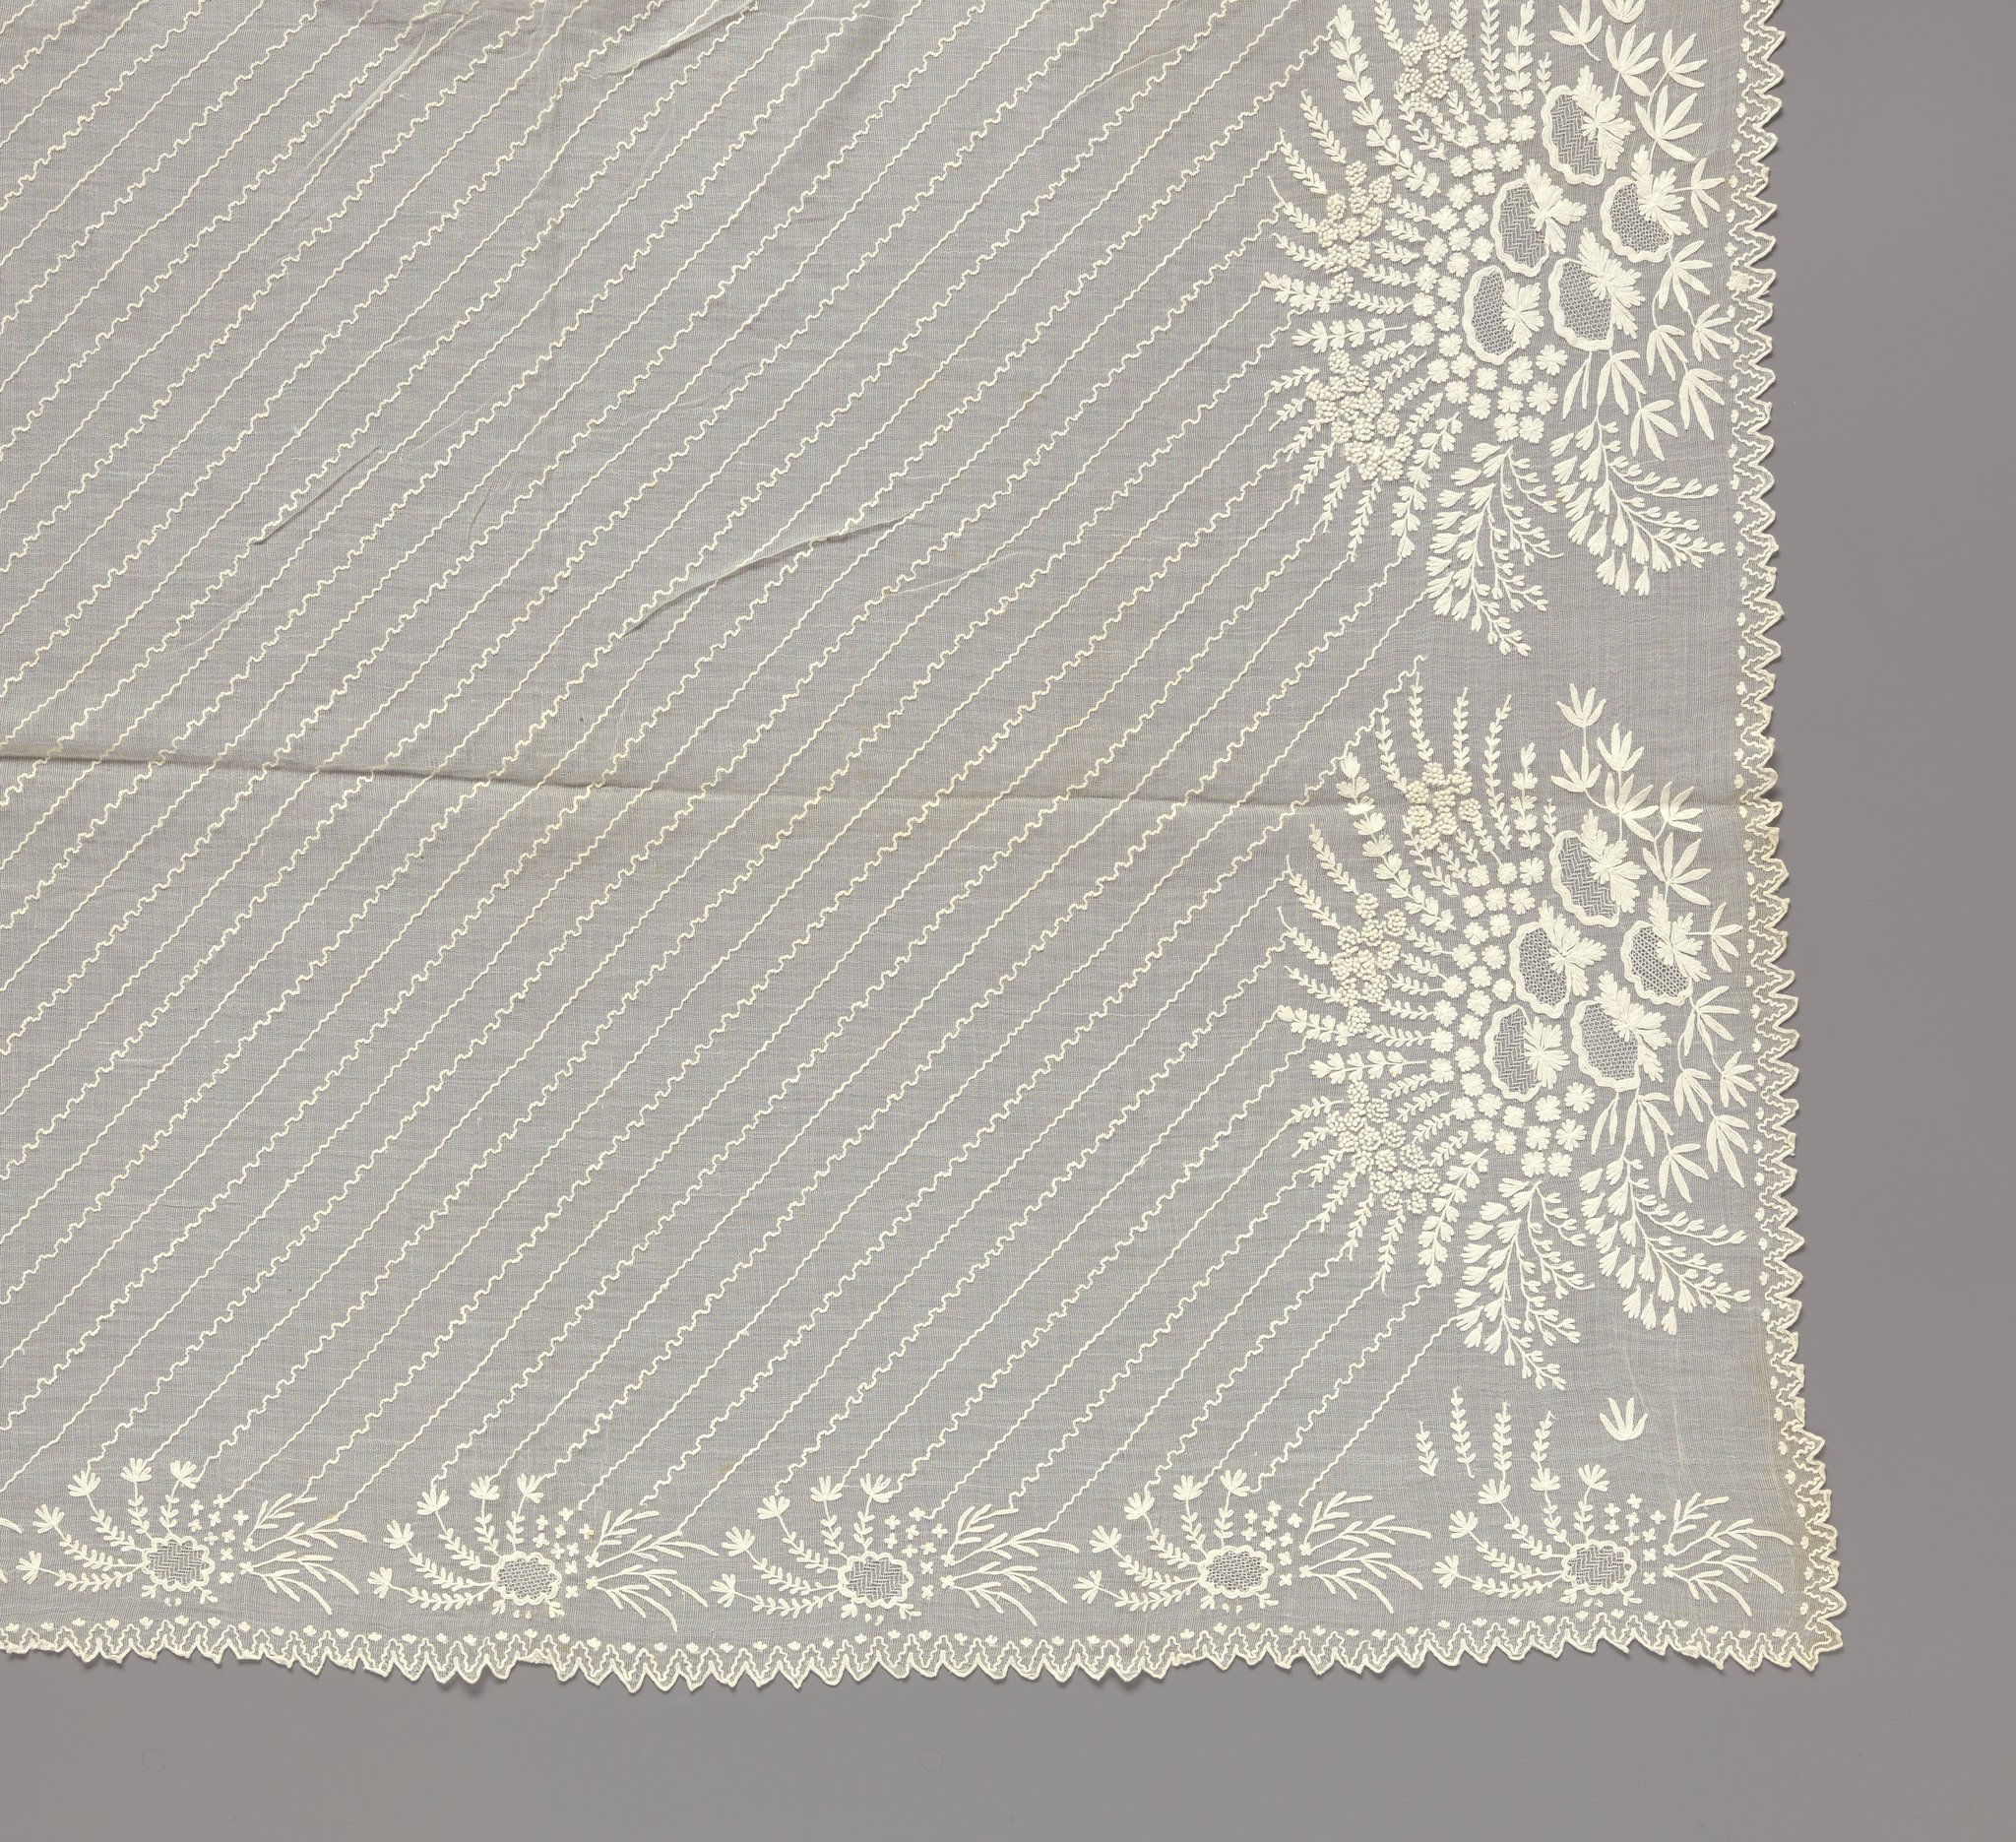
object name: christening veil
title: Bruidssluier of doopsluier van gaasweefsel met tamboereerwerk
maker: Anonymous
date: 1825-1835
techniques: embroidered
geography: netherlands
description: Bruidssluier of doopsluier van naturelkleurig kantborduurwerk, tamboereerwerk. De bloemharten zijn van werk met samengetrokken draden. Op het gaas zijn diagonalen lijnen geborduurd, om en om met vlakkere en een diepere golfjes. De benedenrand heeft grote liggende ovalen, die asymmetrische zijn samengesteld van bloemen en bloemaren die uitstralen naar links, boven en rechts. De zijranden hebben kleinere, luchtigere staande ovalen, passend bij de grotere. Aan drie zijden is de sluier omrand met een fijne puntrand.